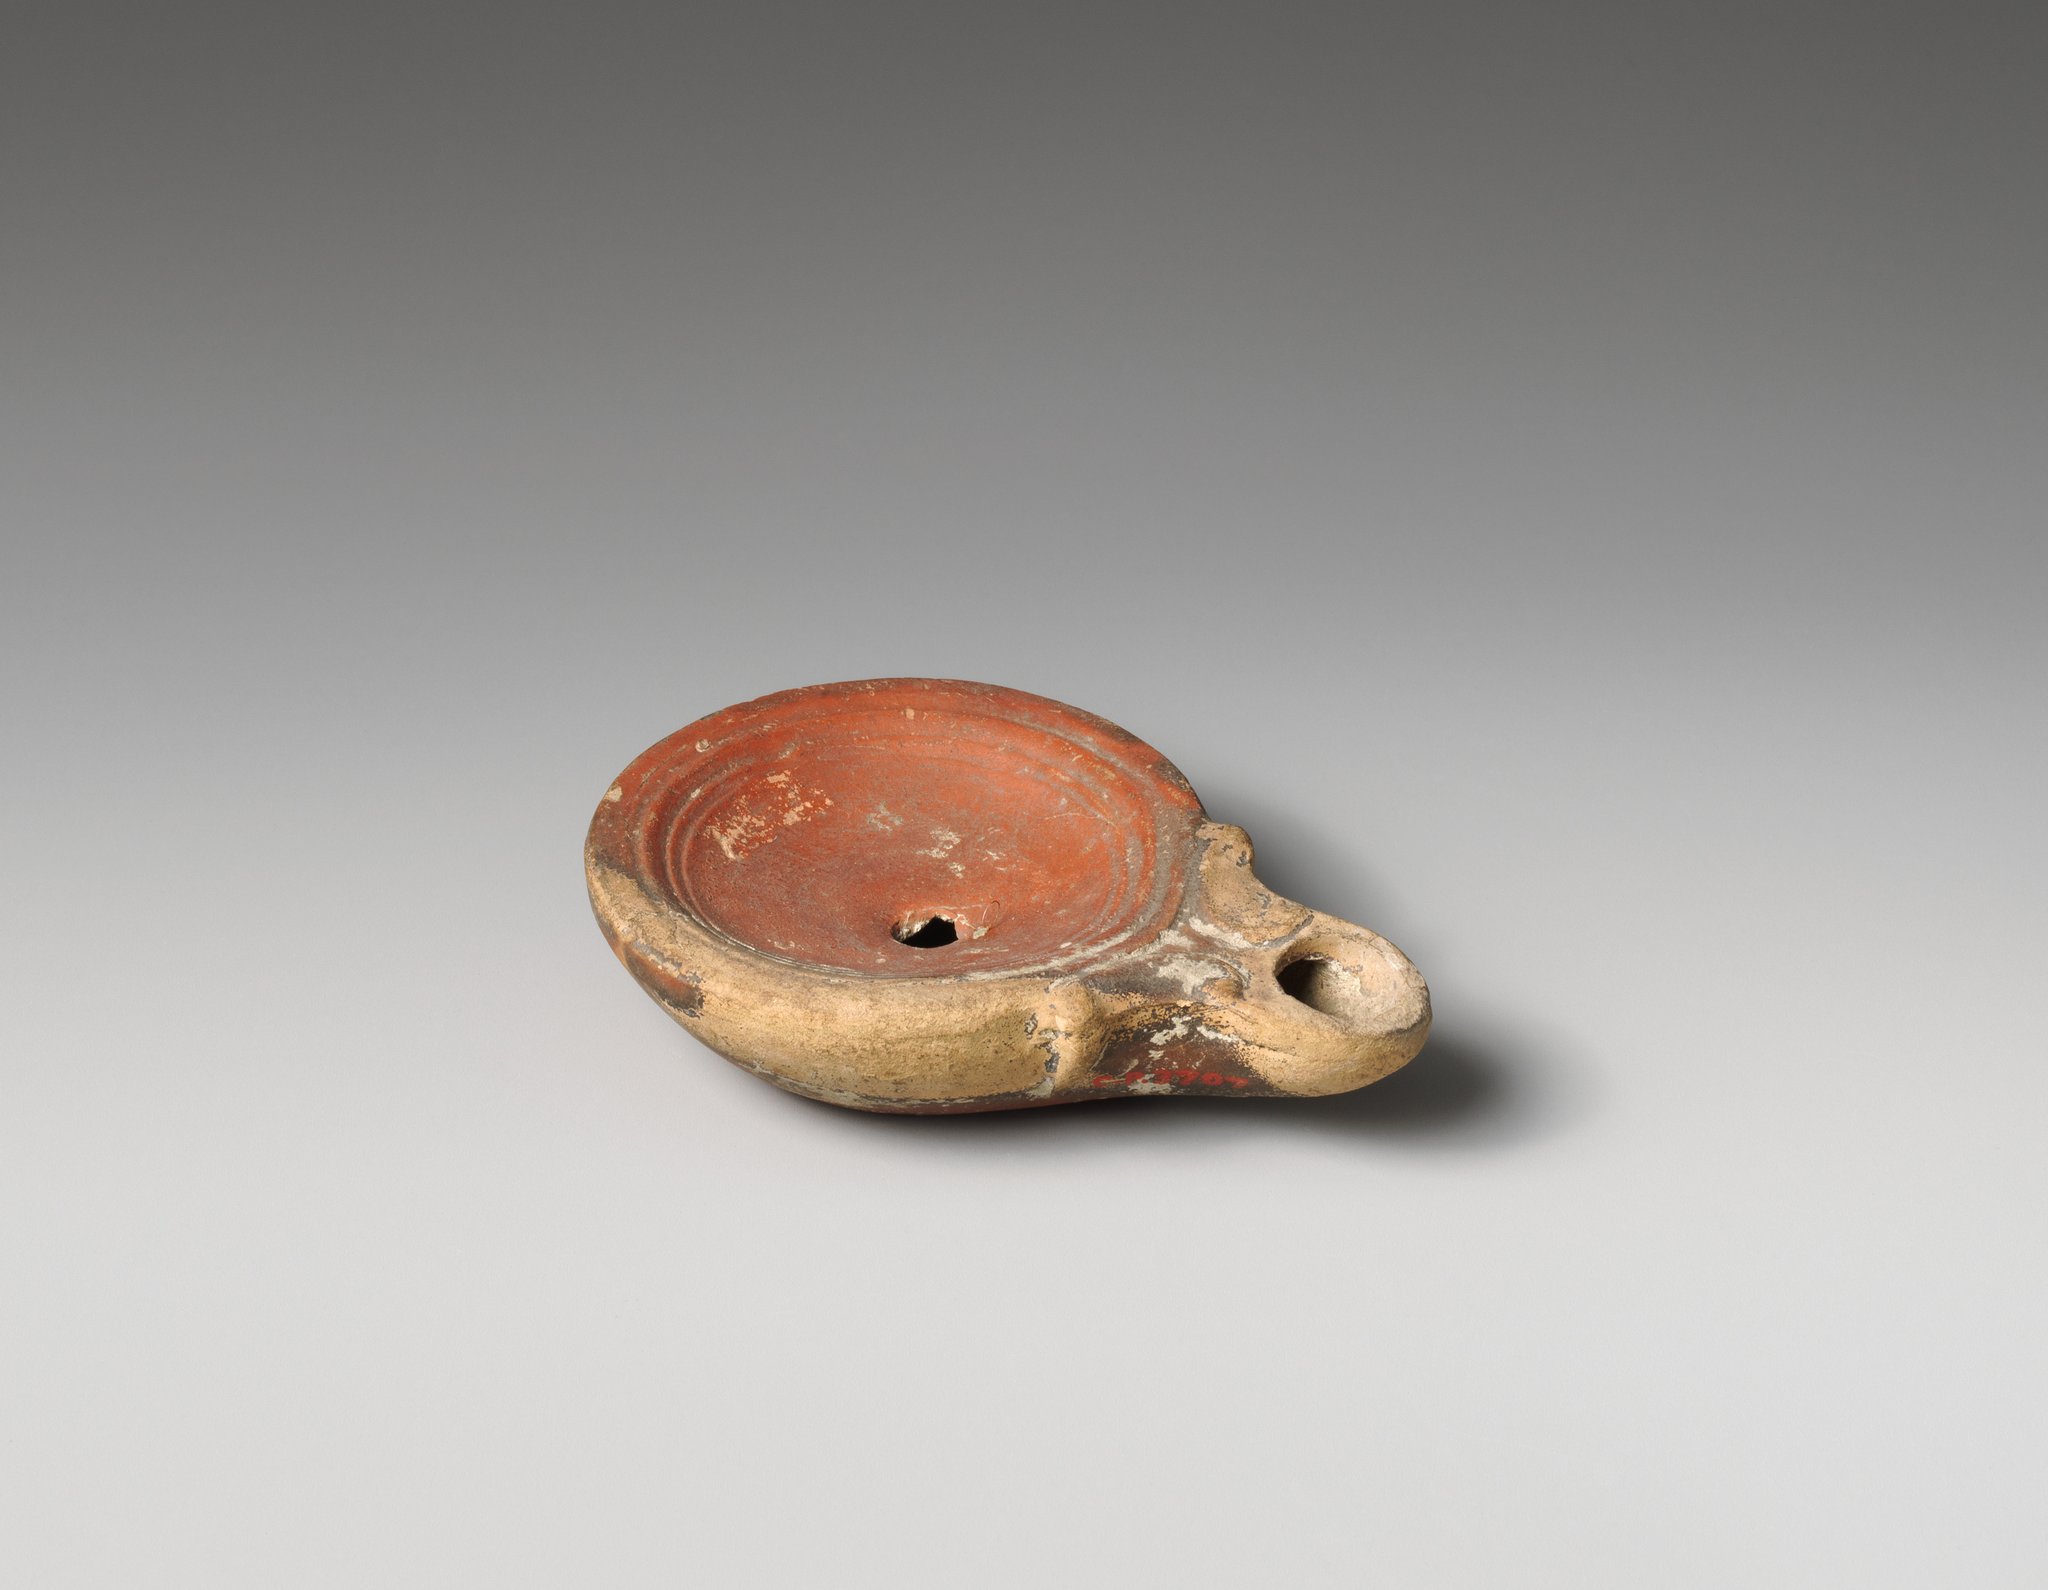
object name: lamp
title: Tarracotta oil lamp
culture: roman, cypriot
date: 40-100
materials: terracotta